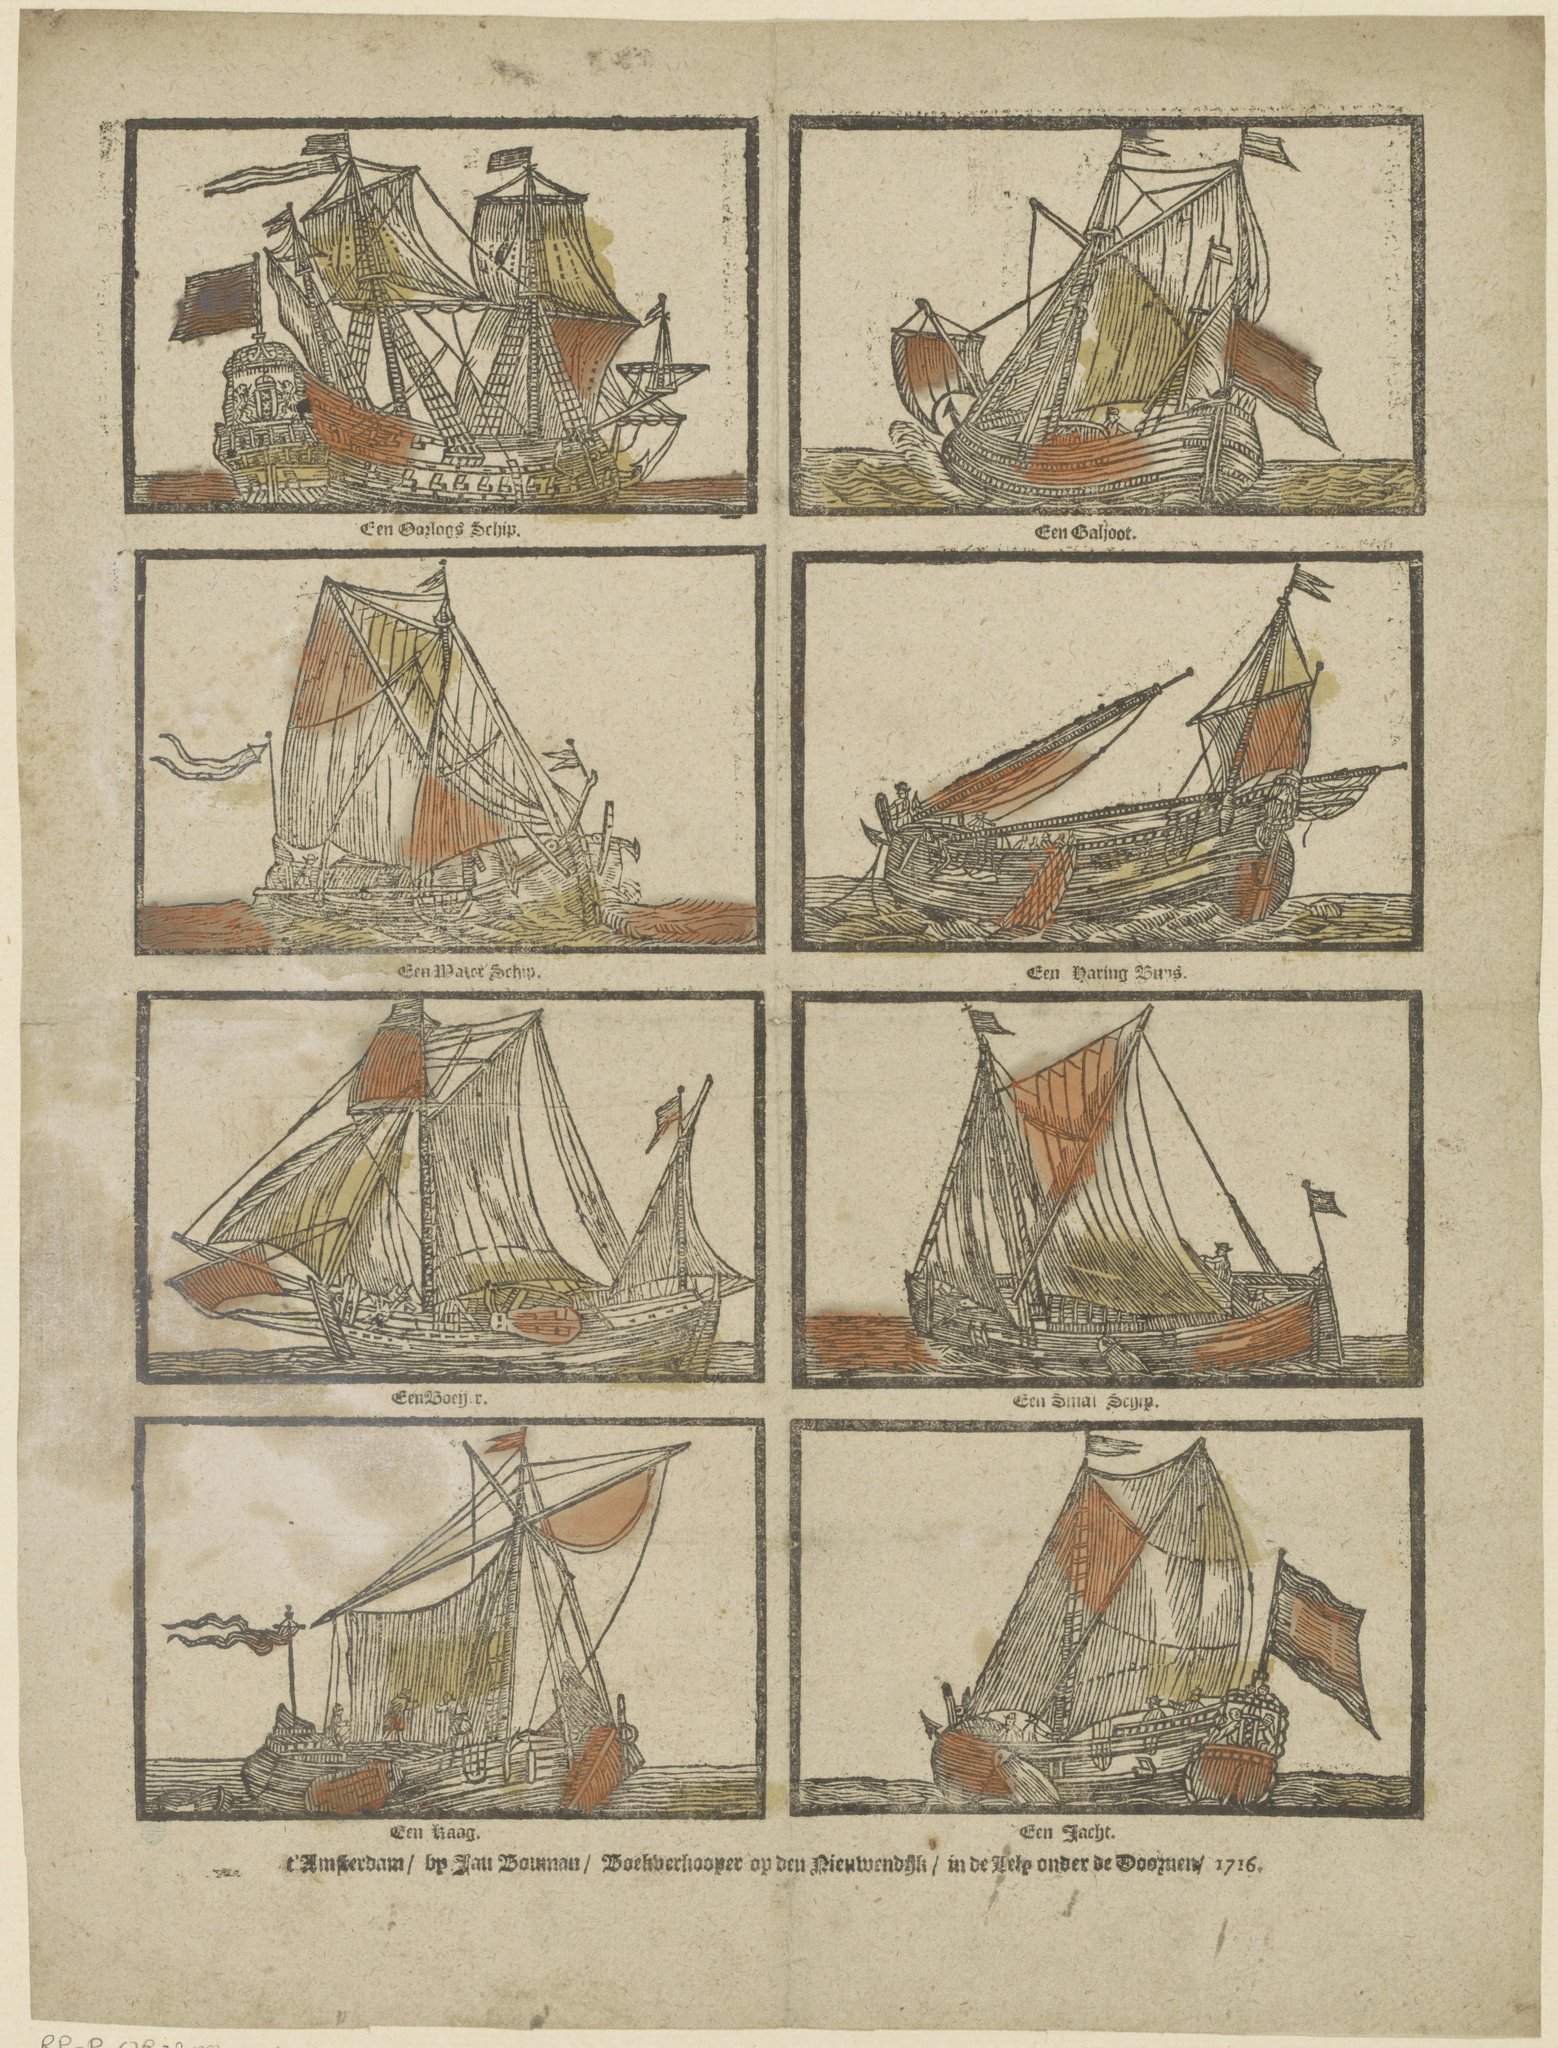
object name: print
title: Schepen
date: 1716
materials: paper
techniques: colour, letterpress printing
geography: amsterdam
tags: ships (in general)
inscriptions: collector's mark: Lugt 2760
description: Blad met 8 voorstellingen van verschillende schepen, zoals een oorlogsschip, een waterschip en een jacht. Onder elke voorstelling de naam van het soort schip.